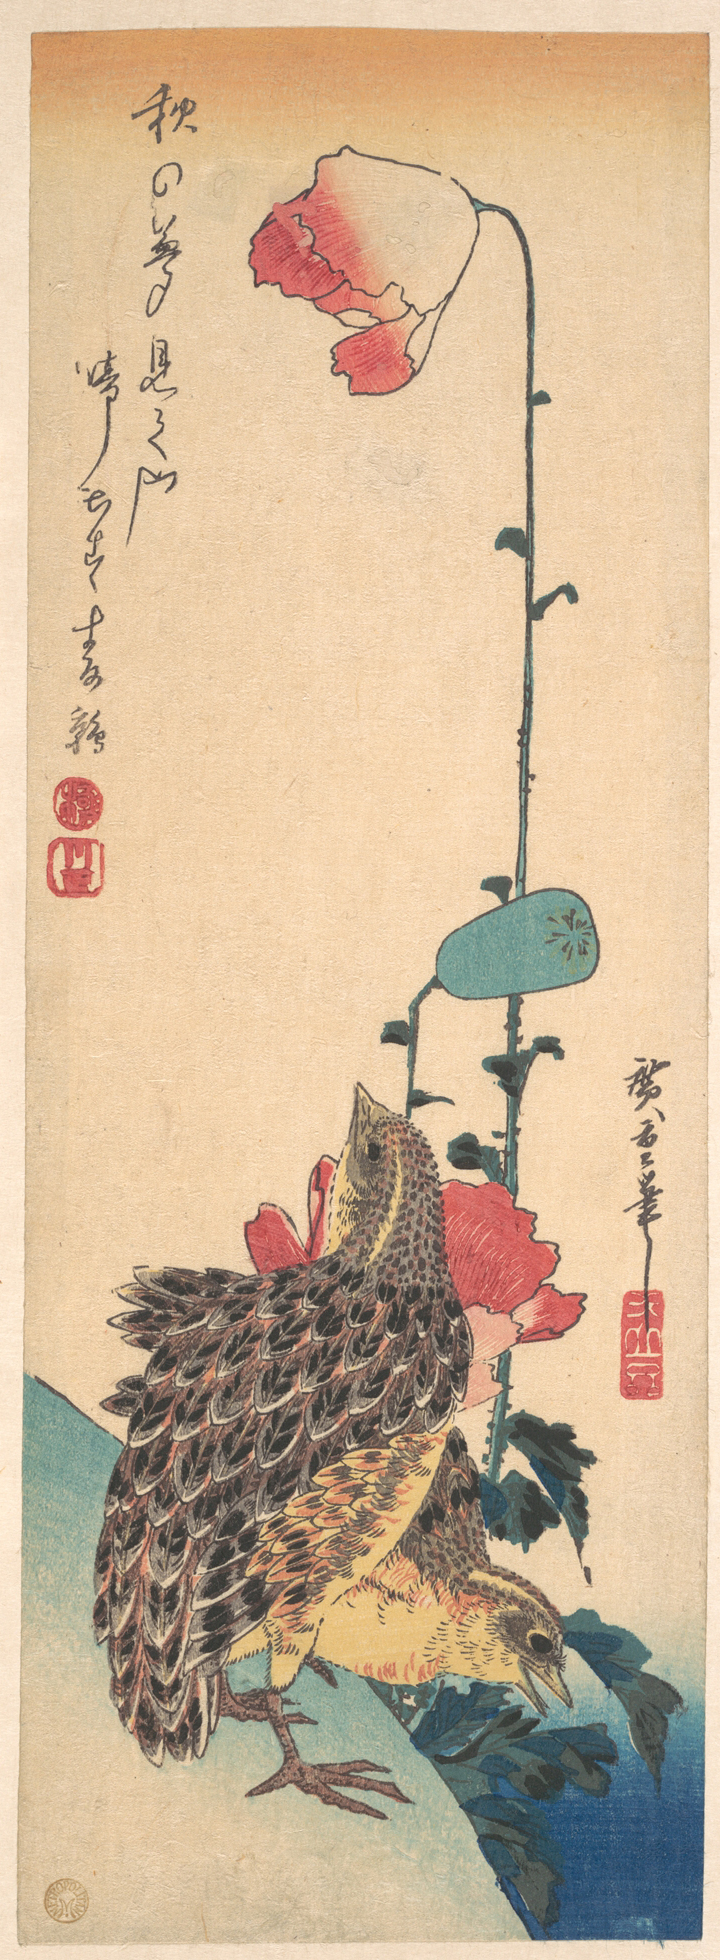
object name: print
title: A Pair of Quails and Poppies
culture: japanese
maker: utagawa hiroshige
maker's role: artist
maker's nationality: japanese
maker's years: 1797-1858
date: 1835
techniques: woodblock print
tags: birds,poppies